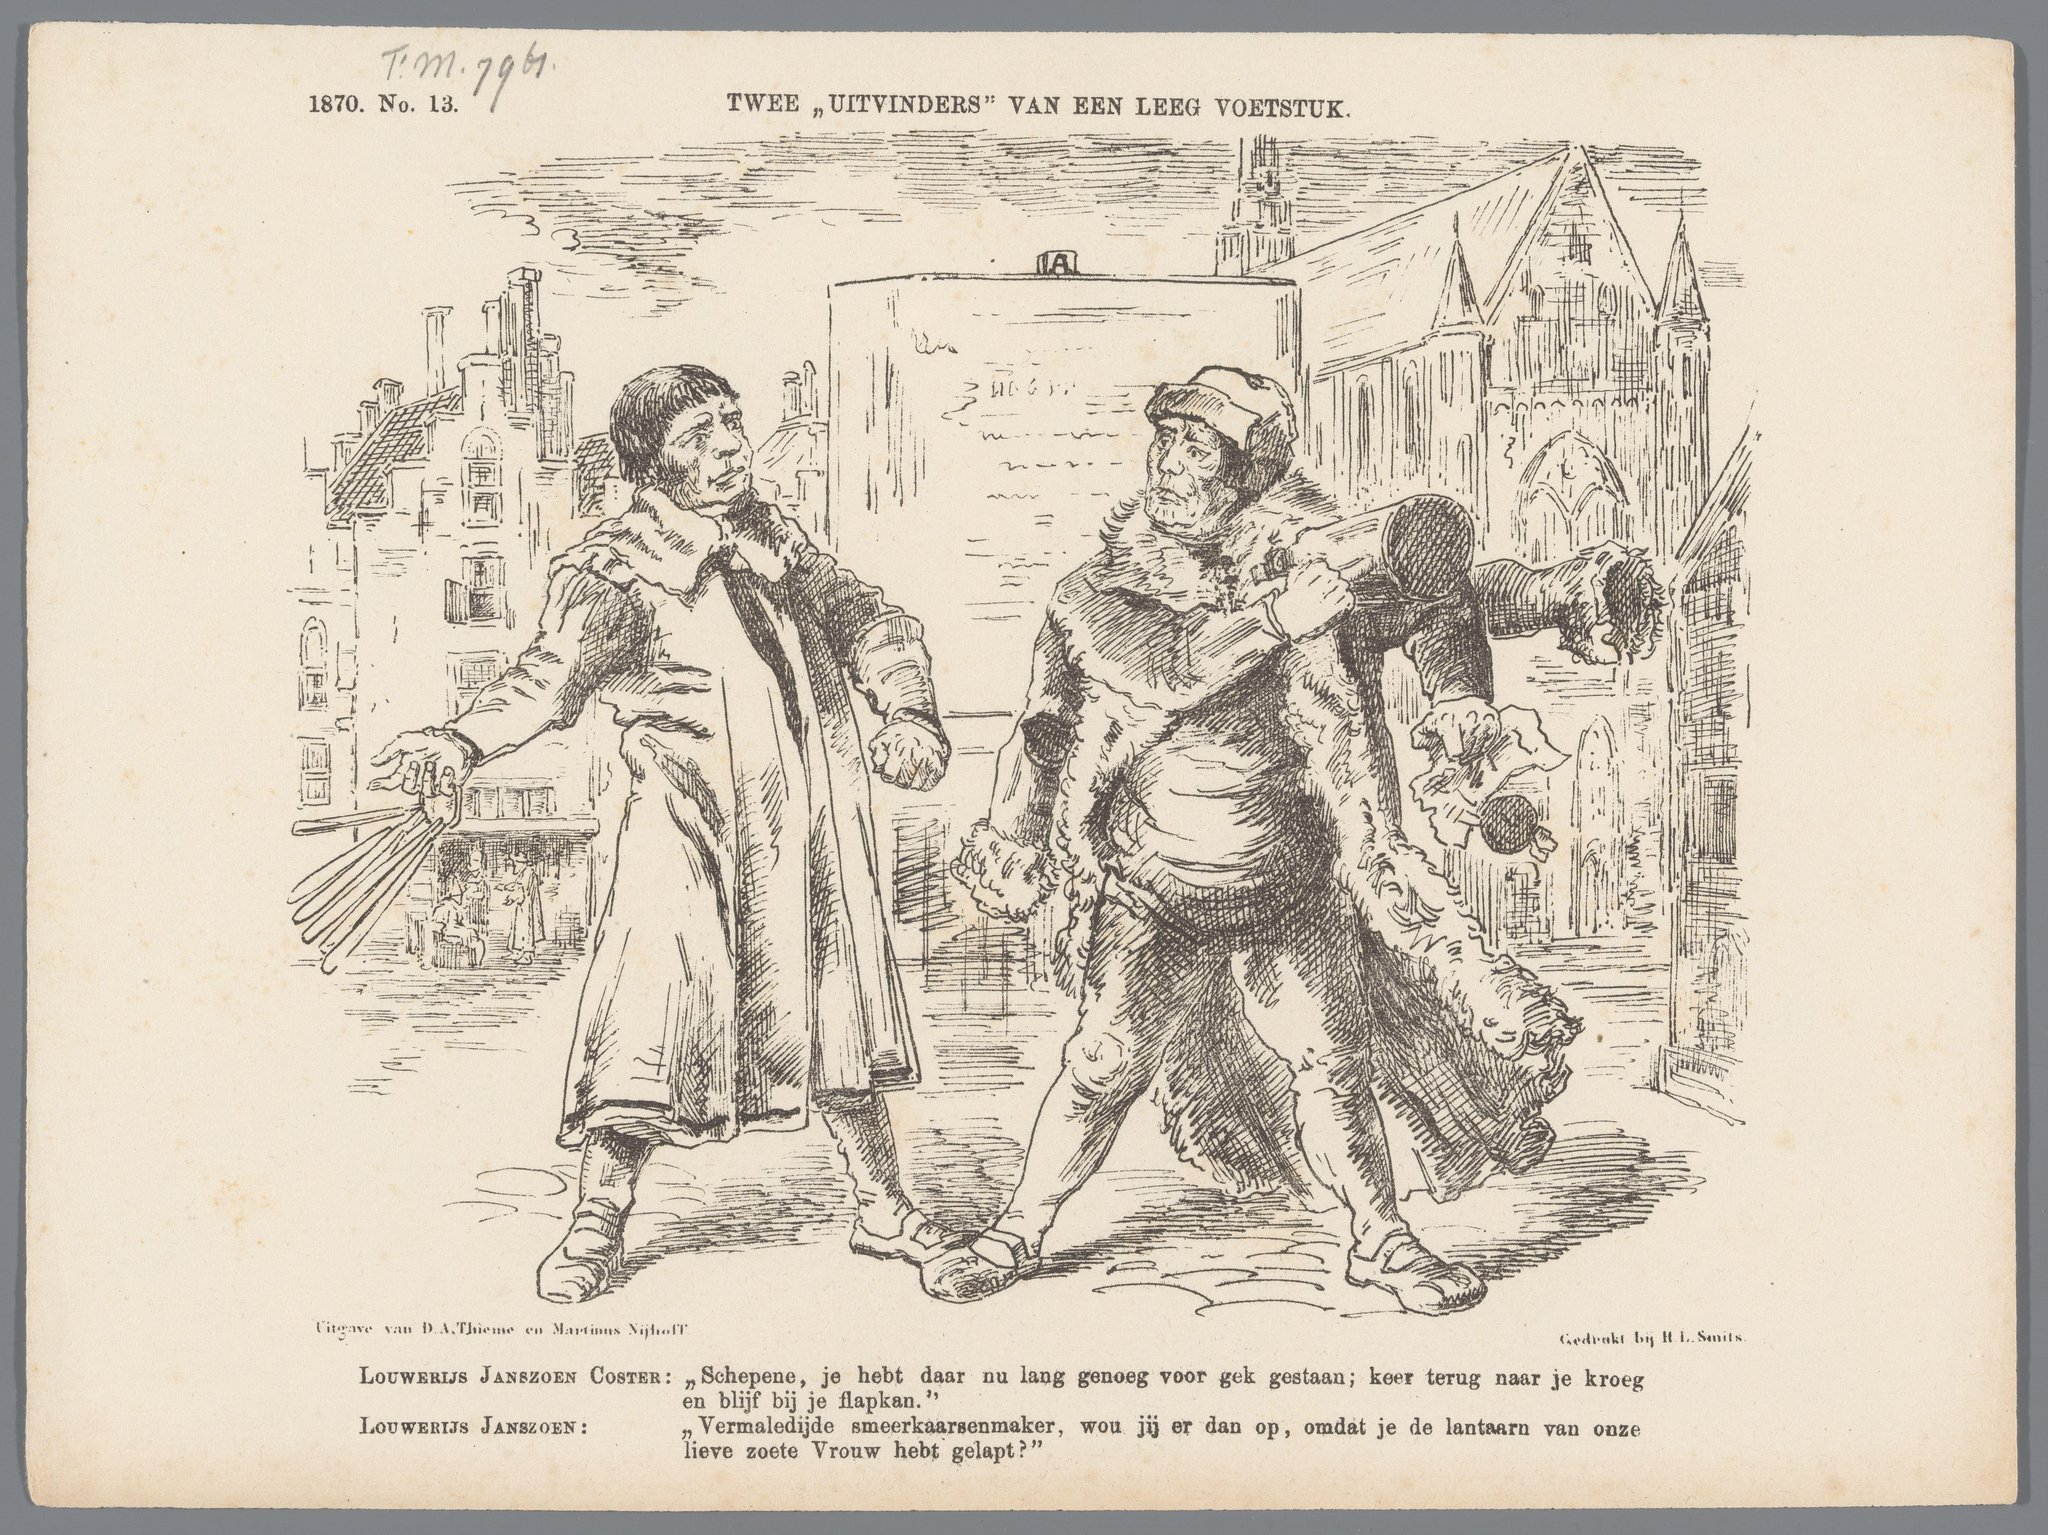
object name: cartoon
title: Spotprent over het standbeeld van Coster in Haarlem, 1870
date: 1870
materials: paper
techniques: lithograph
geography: arnhem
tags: haarlem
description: Spotprent over het standbeeld van Coster in Haarlem. De kaarsenmaker Coster twist met de herbergier Coster wie van beiden als standbeeld zal prijken van de uitvinder van de boekdrukkunst. Naar aanleiding van Dr. A. v.d. Linde's Costerlegende. Plaat verschenen bij het weekblad De Nederlandsche Spectator, nr. 13, 1870.